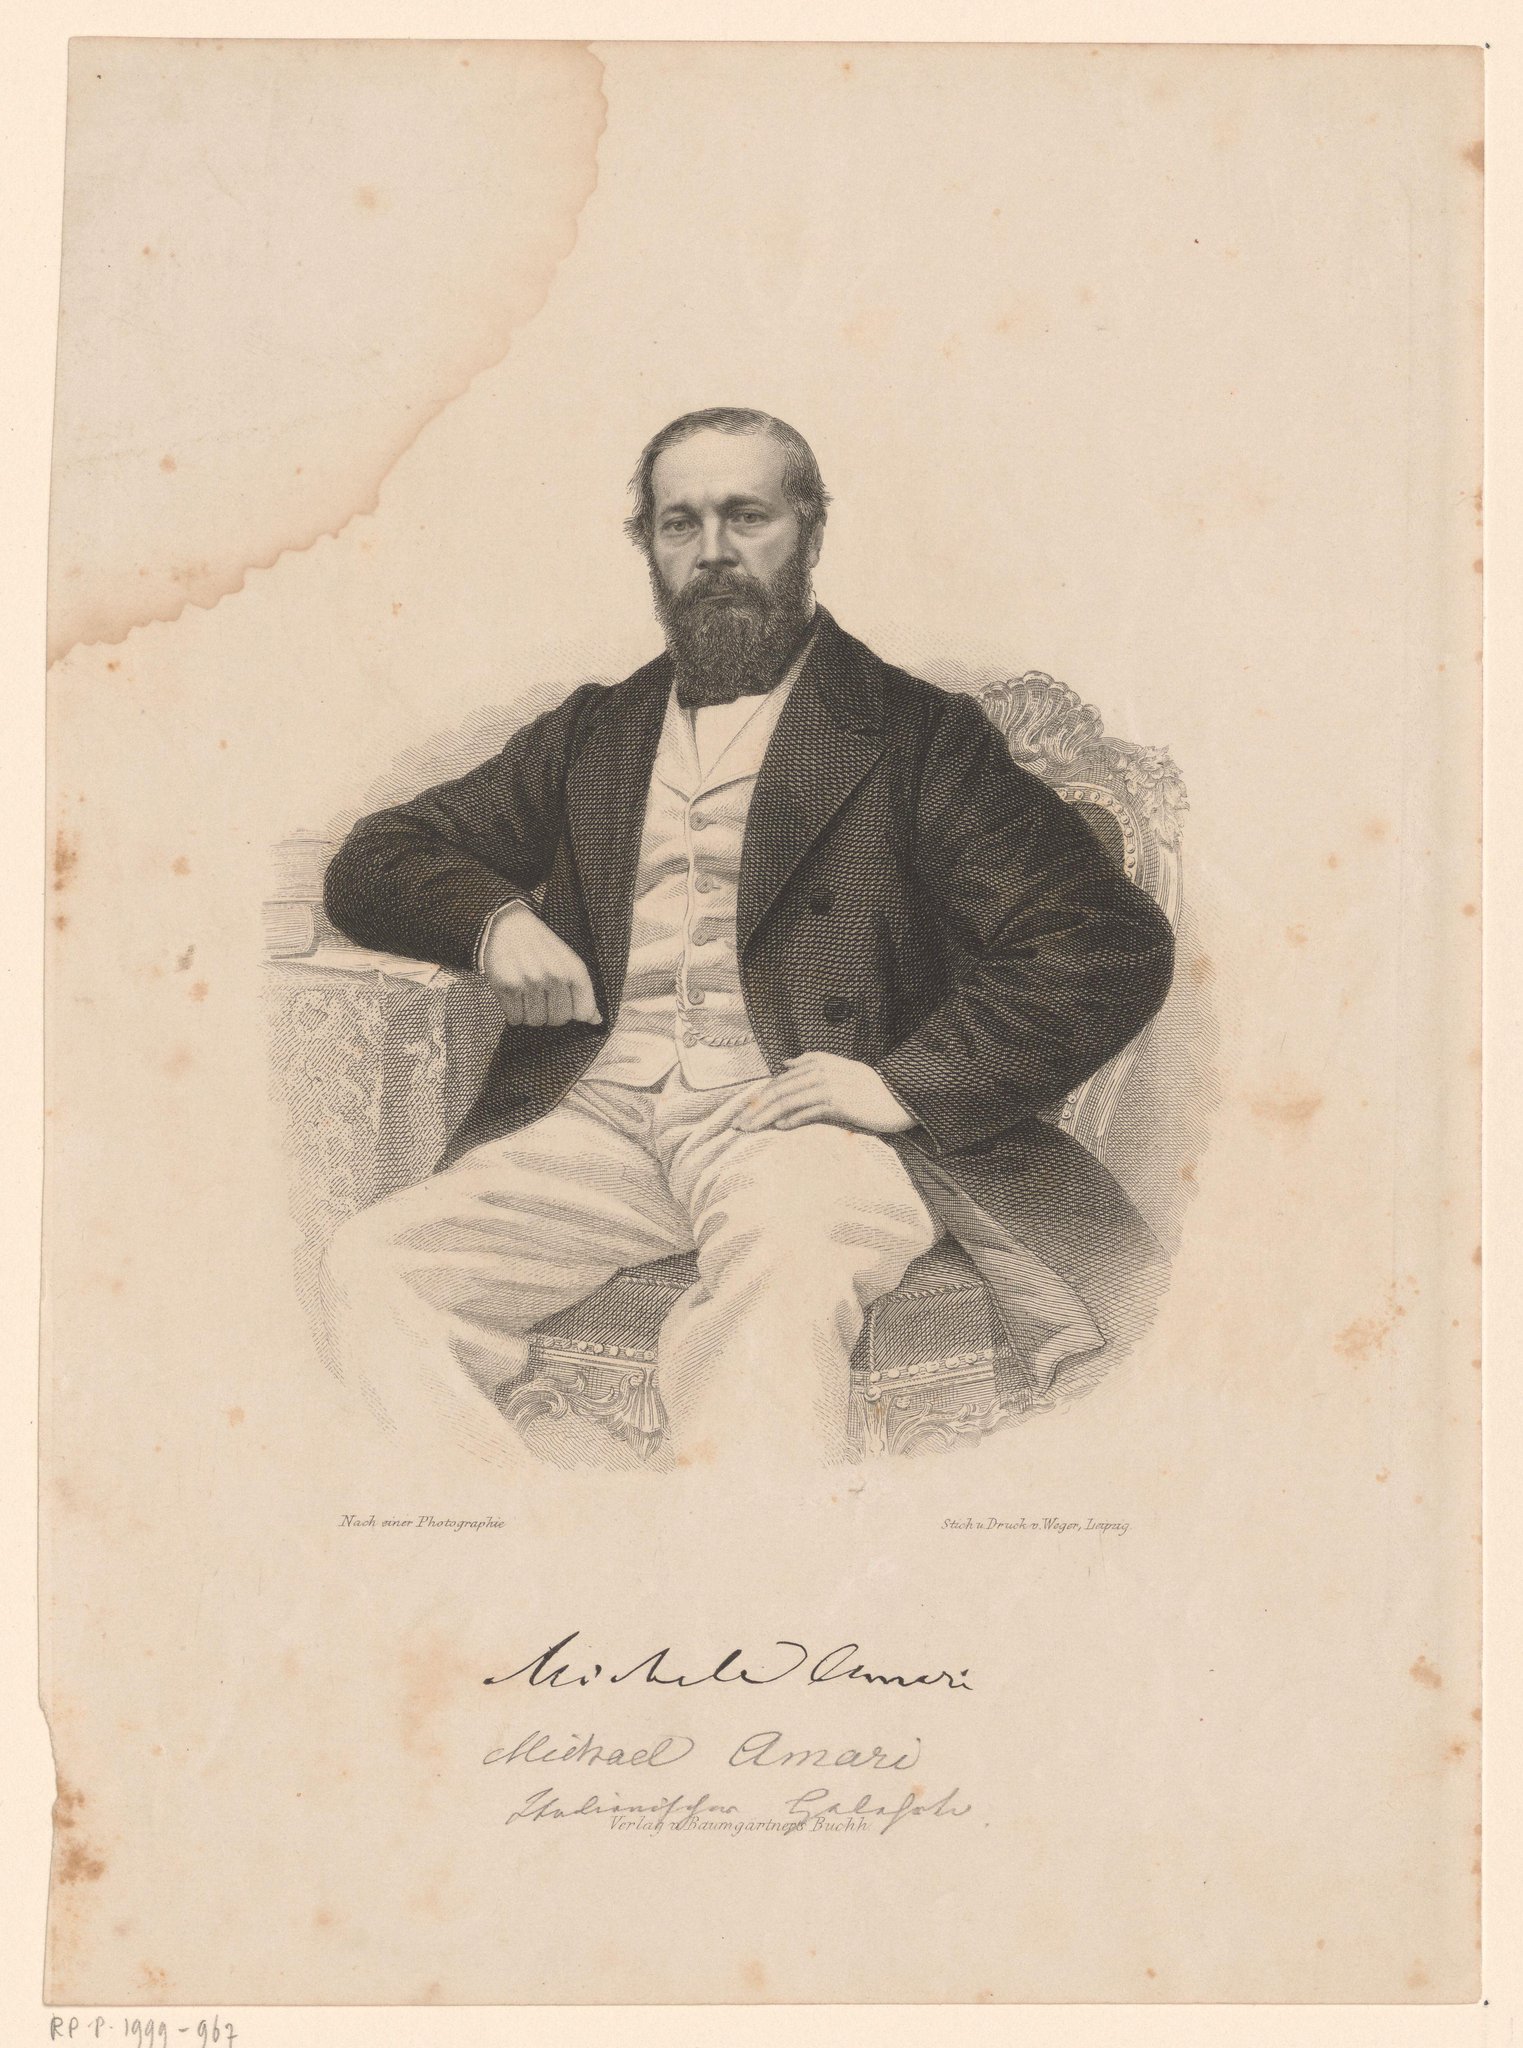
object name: print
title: Portret van Michele Amari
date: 1850-1899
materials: paper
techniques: engraving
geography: leipzig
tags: historical persons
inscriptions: collector's mark: Lugt 2760, collector's mark: ‘Franz Radest[...]’, annotation: ‘Michael Amari/ Italienischer Galafoto’, collector's mark: Lugt 2228